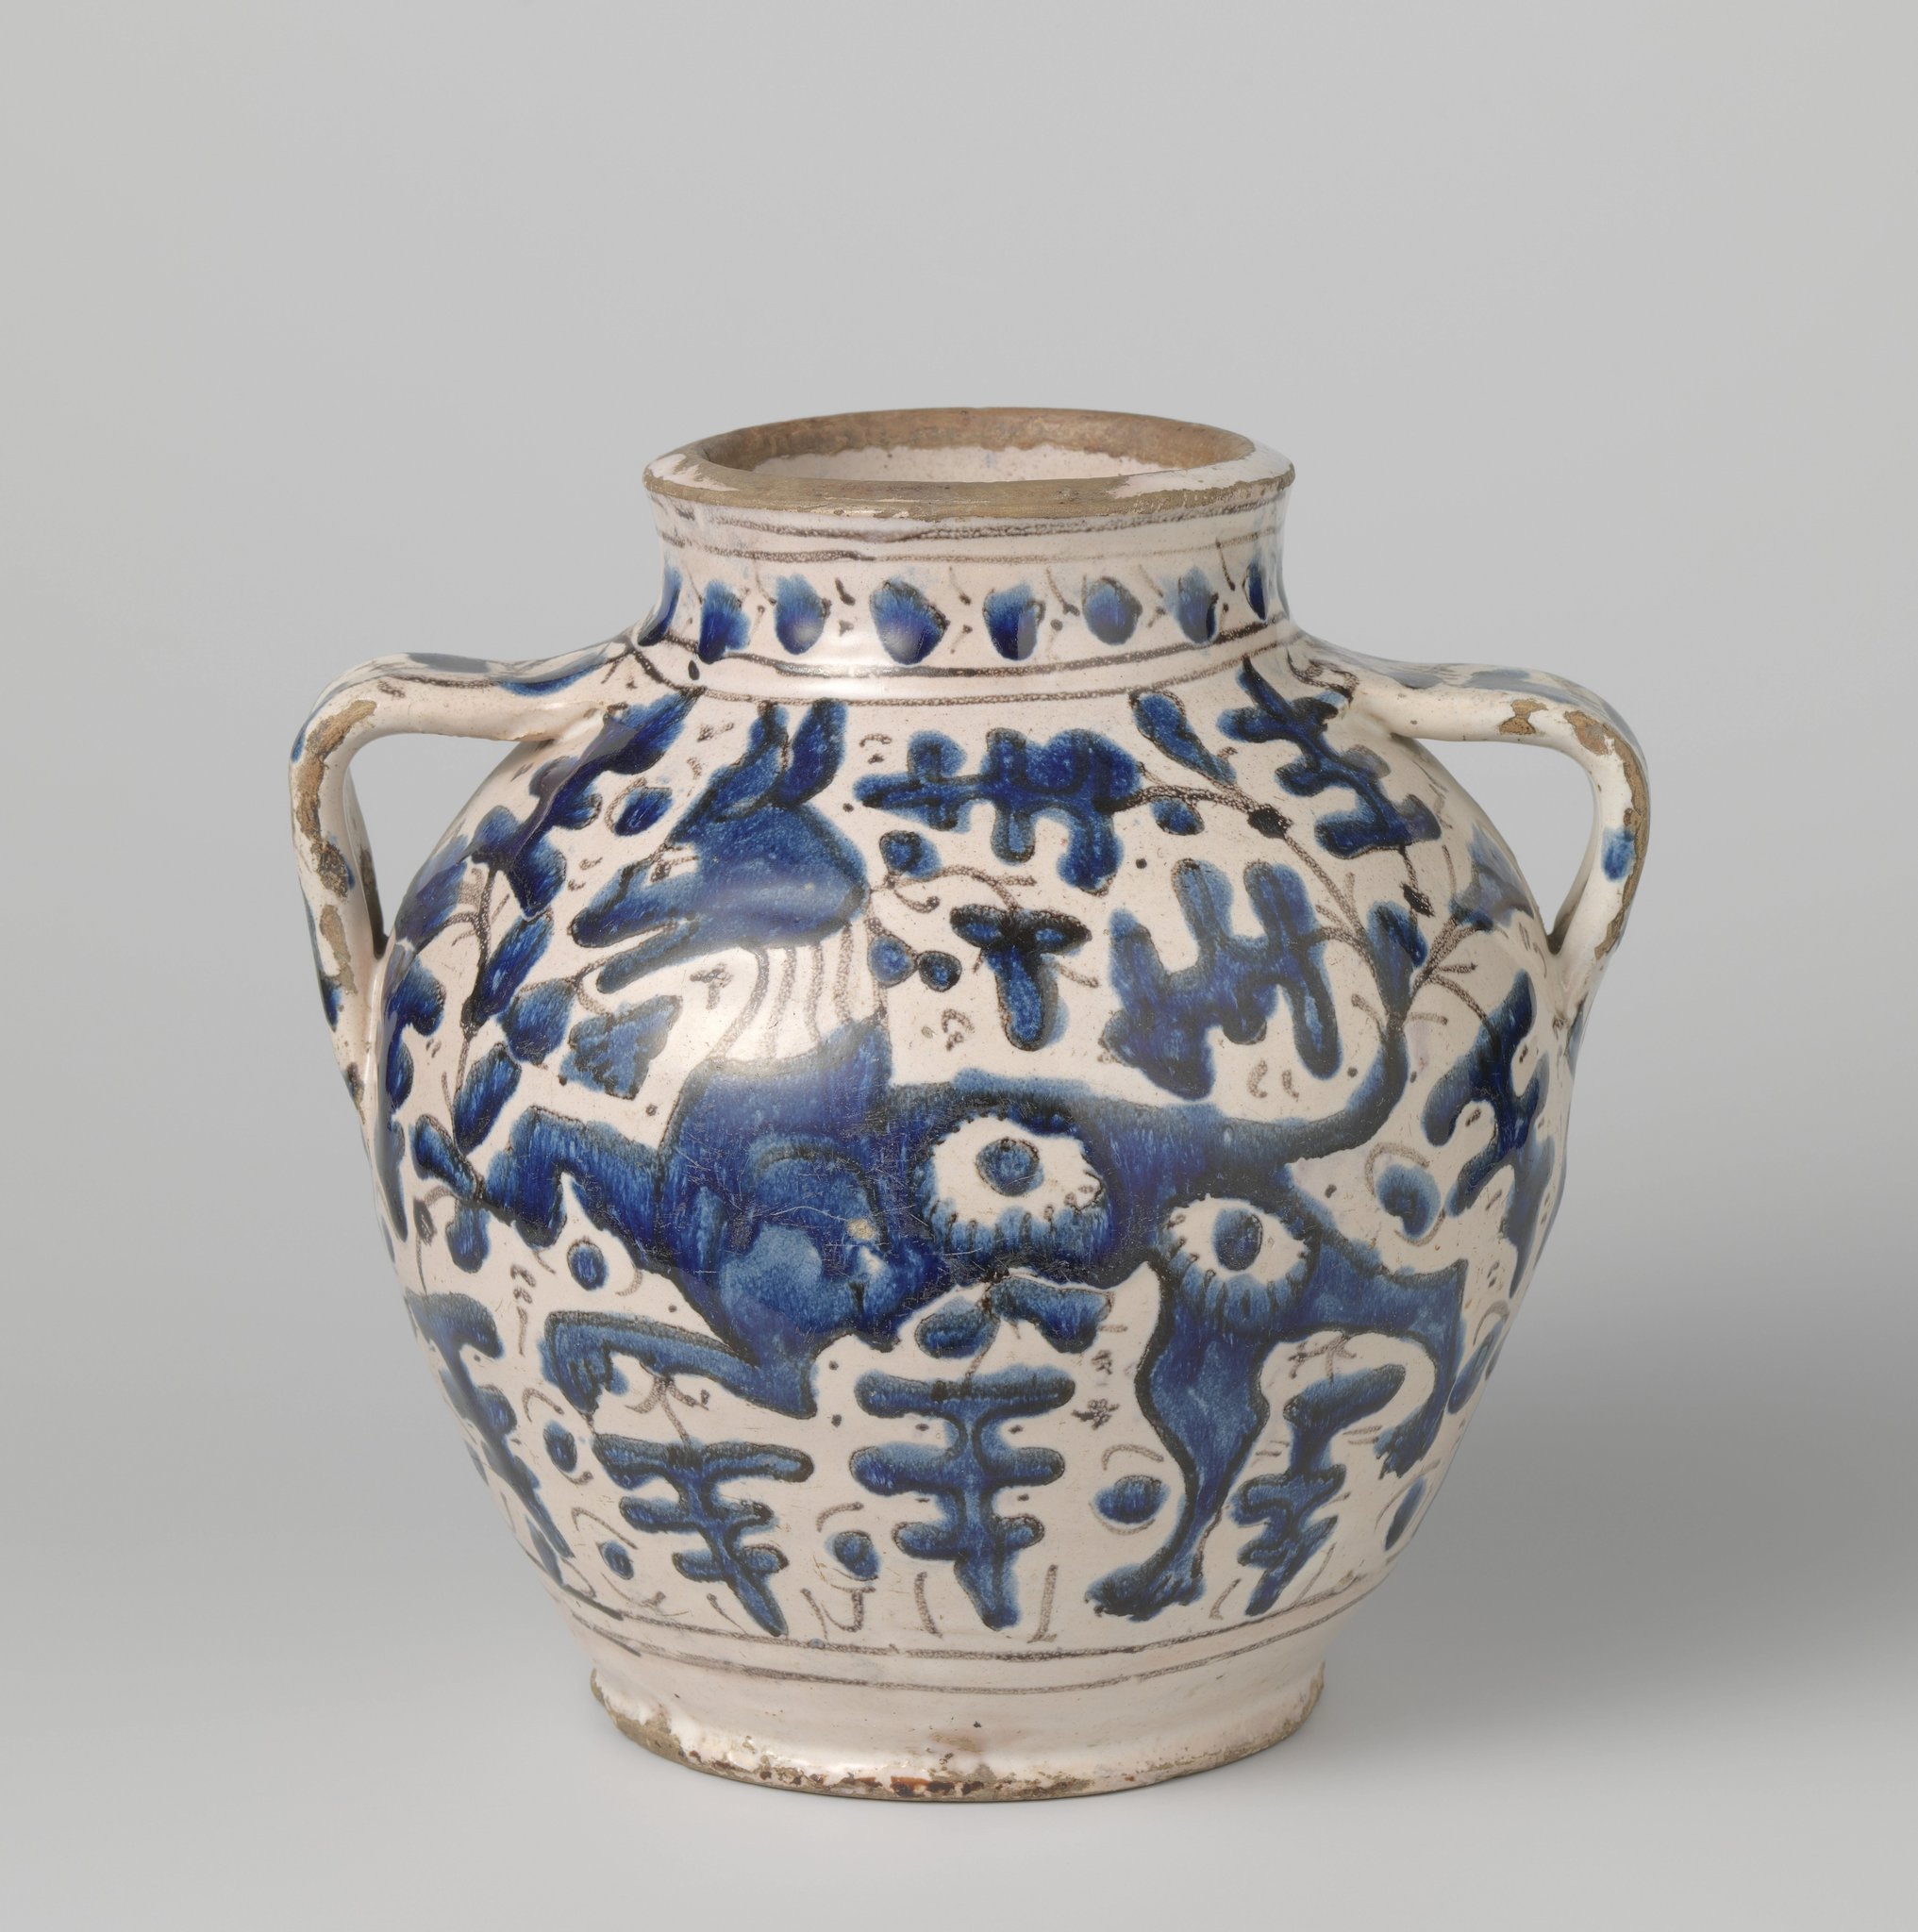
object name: pot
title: Kan met twee hoekige oren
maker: Anonymous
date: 1450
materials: earthenware, glaze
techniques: maiolica, painted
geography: florence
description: Jar with a leaping dog. Florence, c. 1420 - 1460.